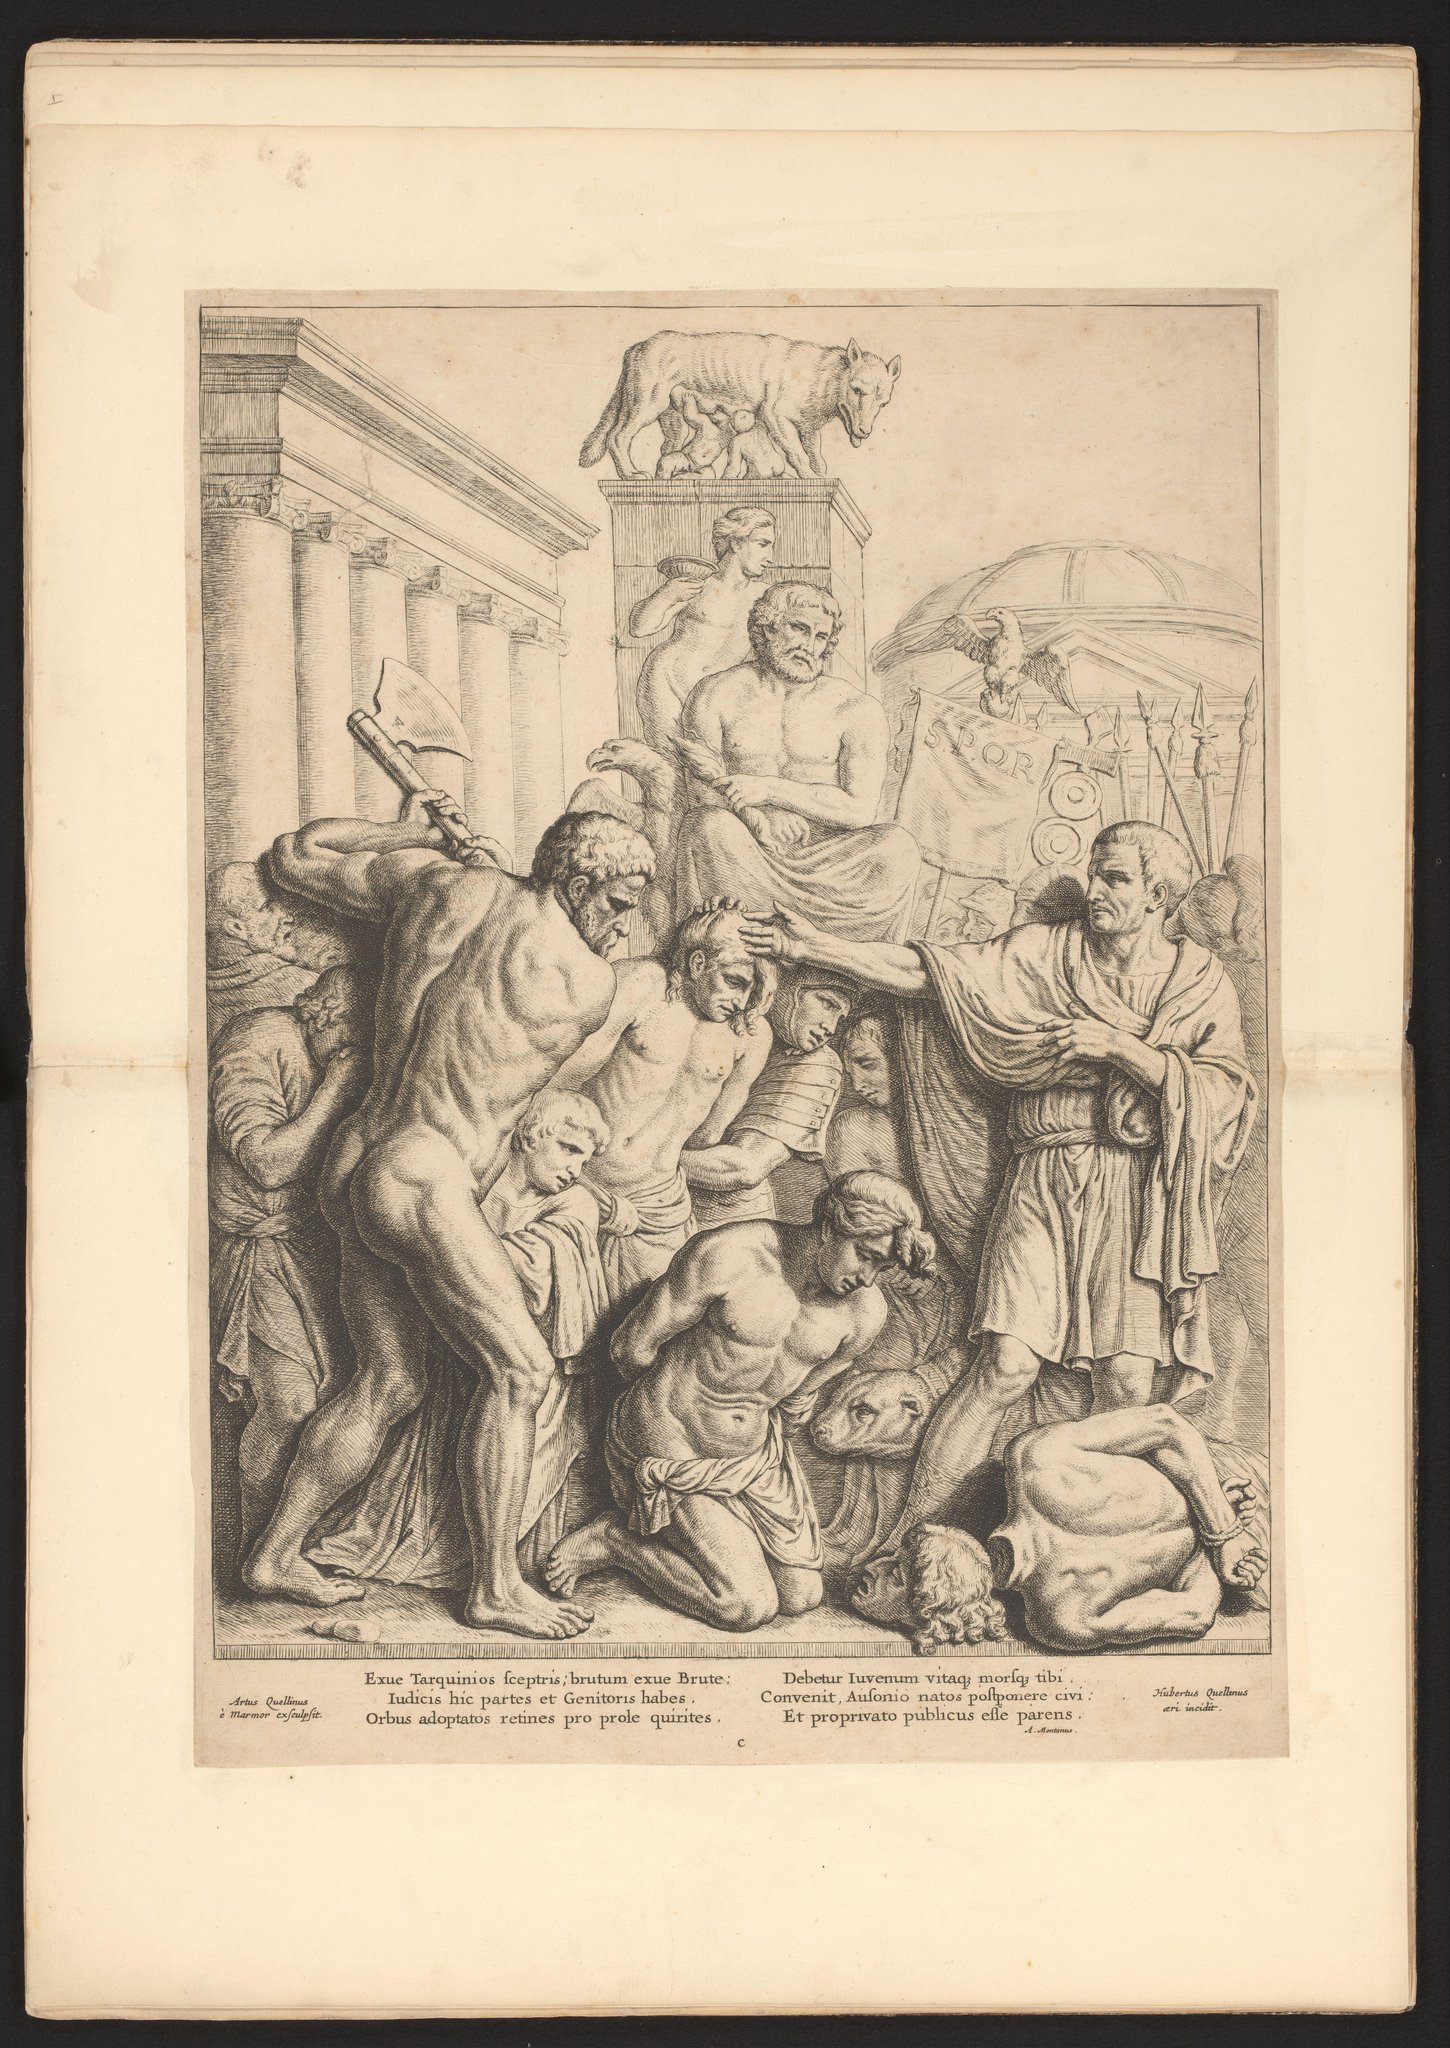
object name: print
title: Reliëf met het oordeel van Lucius Junius Brutus in de Vierschaar van het Stadhuis op de Dam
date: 1655-1665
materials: paper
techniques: engraving, etching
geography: amsterdam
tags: l. junius brutus has his two sons beheaded because they joined a conspiracy, sculpture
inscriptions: collector's mark: ‘Instituut voor kunst-nijverheidsonderwijs Gabriël Metsustraat No. 16 Amsterdam’, collector's mark: ‘Kunstnijverheidschool Quellinus Amsterdam Frans Halsstraat 14’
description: Prent waarschijnlijk uit: Prima pars. Praecipuarum effigierum ac ornamentorum, amplissimae Curiae Amstelrodamensis (…). Amsterdam: Artus Quellinus (I), 1655. Of uit de editie uit 1665, uitgegeven door Frederik de Wit. Een latere staat werd gebruikt in: Architecture peinture et sculpture de la Maison de Ville d'Amsterdam, representee en CIX. figures en taille-douce (…). Amsterdam: David Mortier, 1719. De latere staat werd ook gebruikt in de uitgave van dit werk door Gerard Valck uit 1719, en in: Bouw schilder en beeldhouwkonst, van het Stadhuis te Amsteldam, vertoont in CIX figuuren (…). Amsterdam: Covens & Mortier & Covens Jr., s.a. (1774-1783).